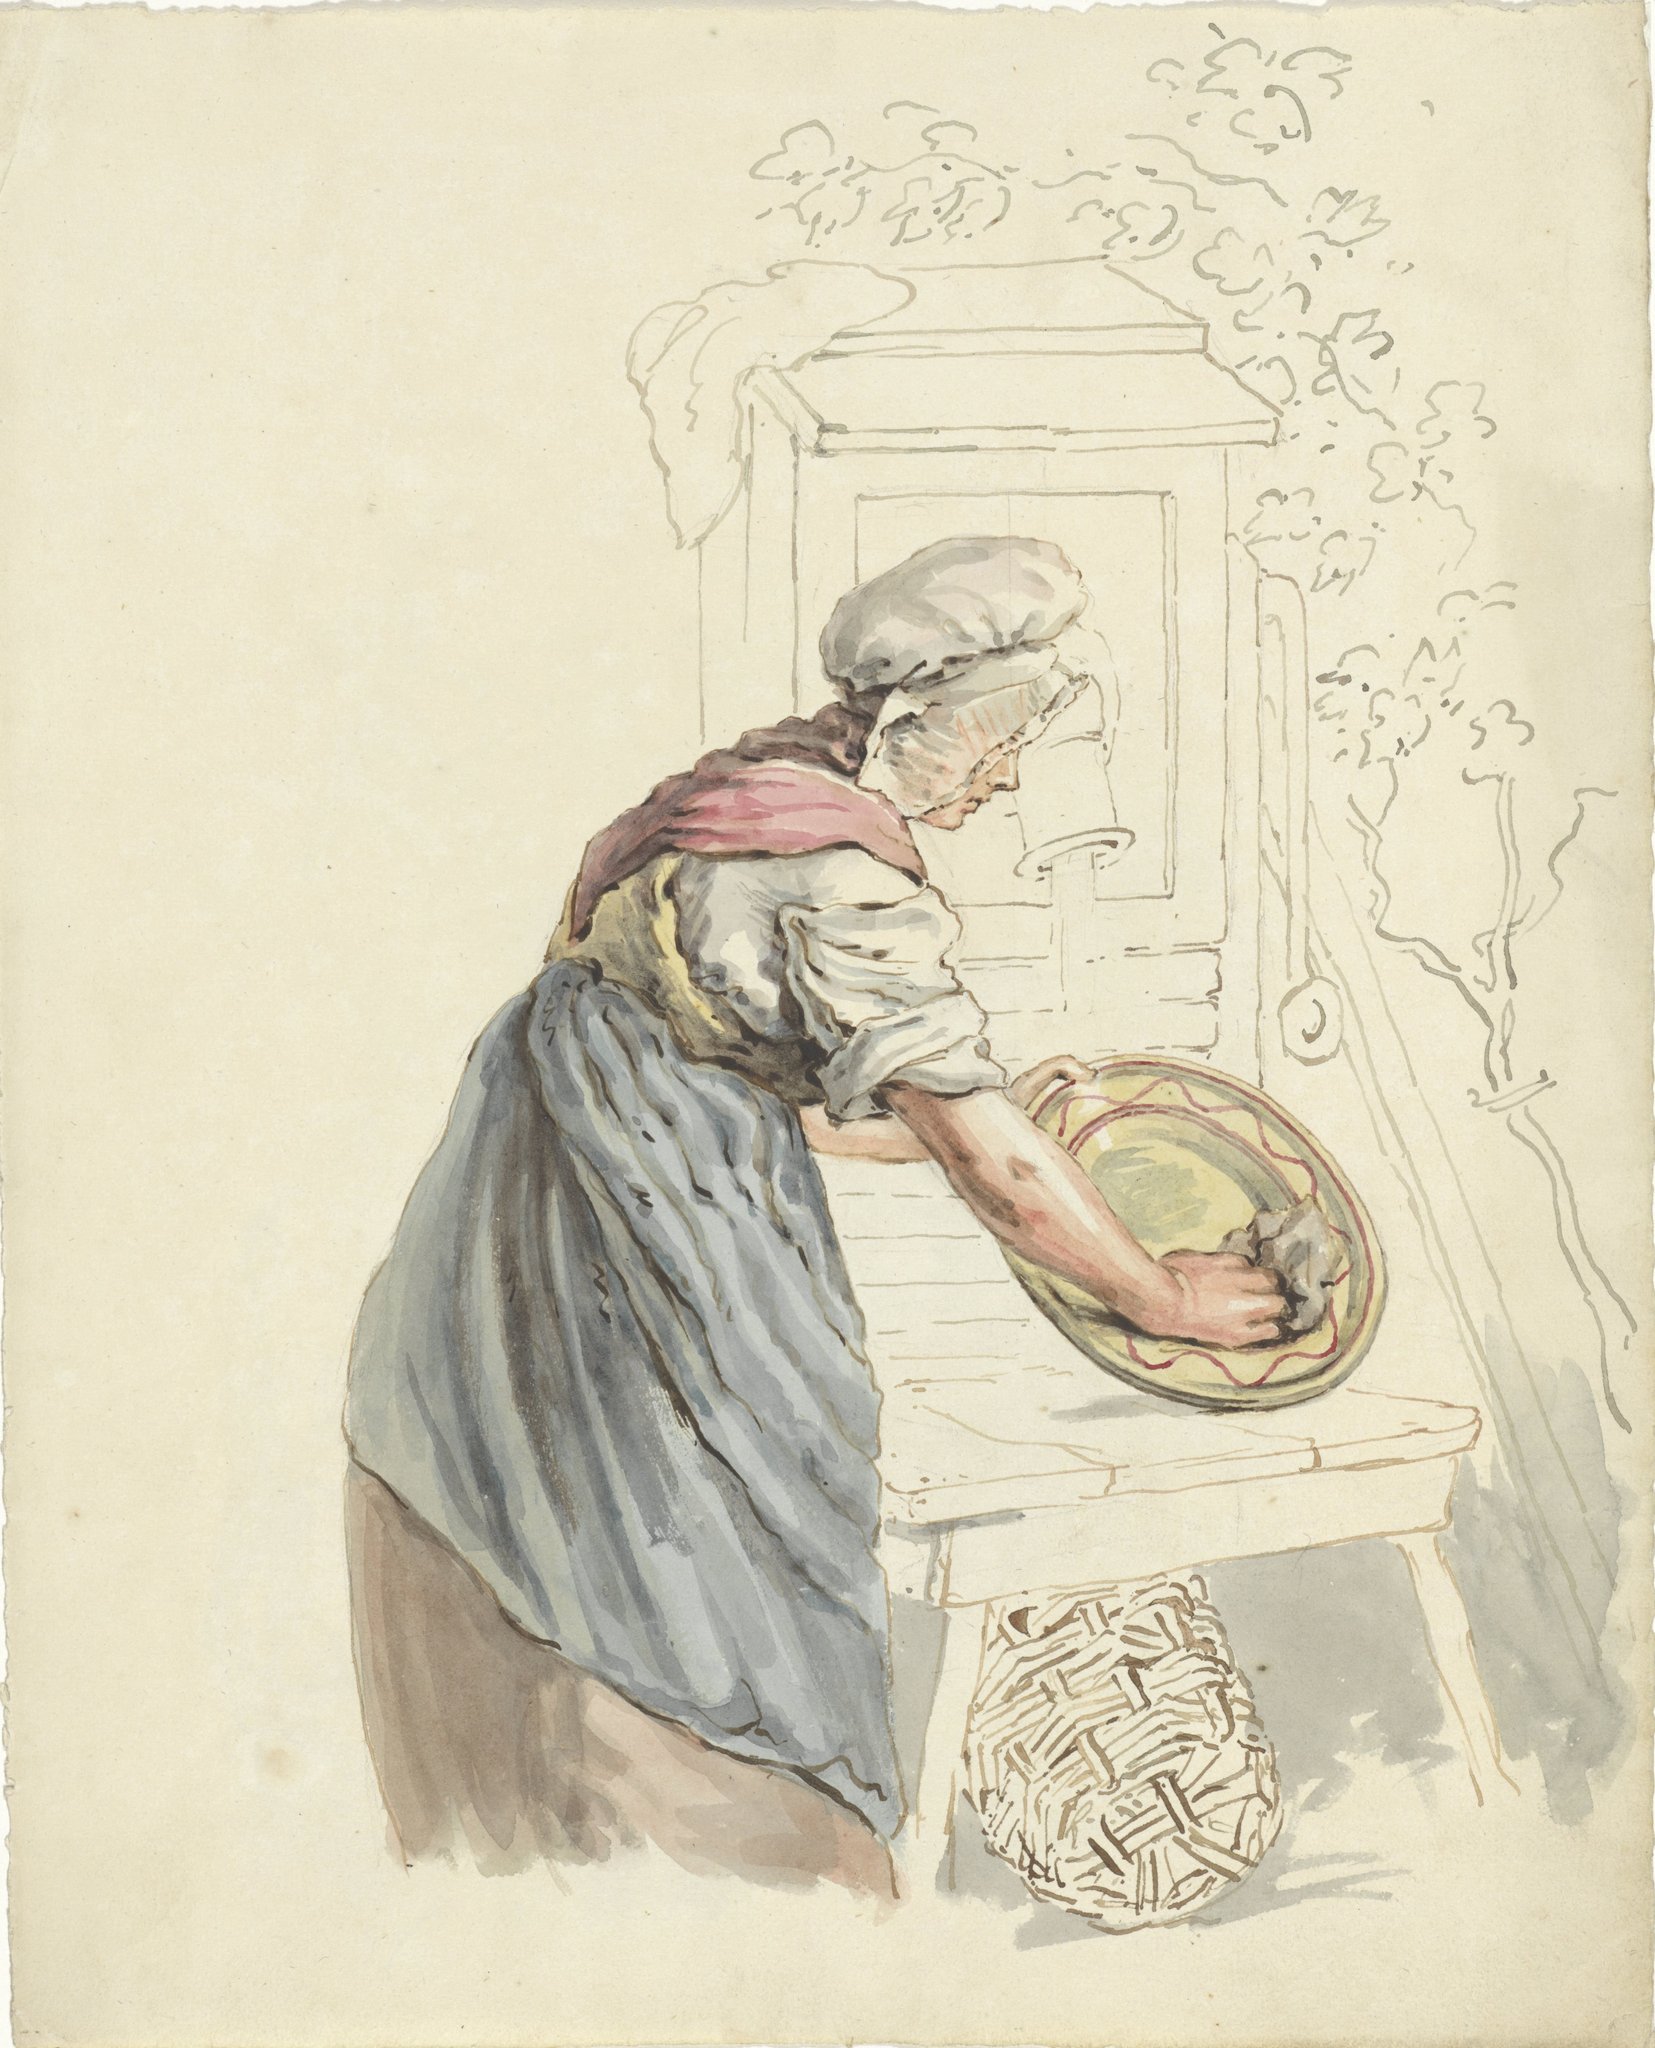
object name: drawing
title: Dienstmeid die bij een waterpomp een schaal afwast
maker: pieter van loon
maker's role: draughtsman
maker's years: 1801-1873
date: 1811-1873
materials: ink, paper, pencil, watercolor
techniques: brush, pen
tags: maid ~ house personnel